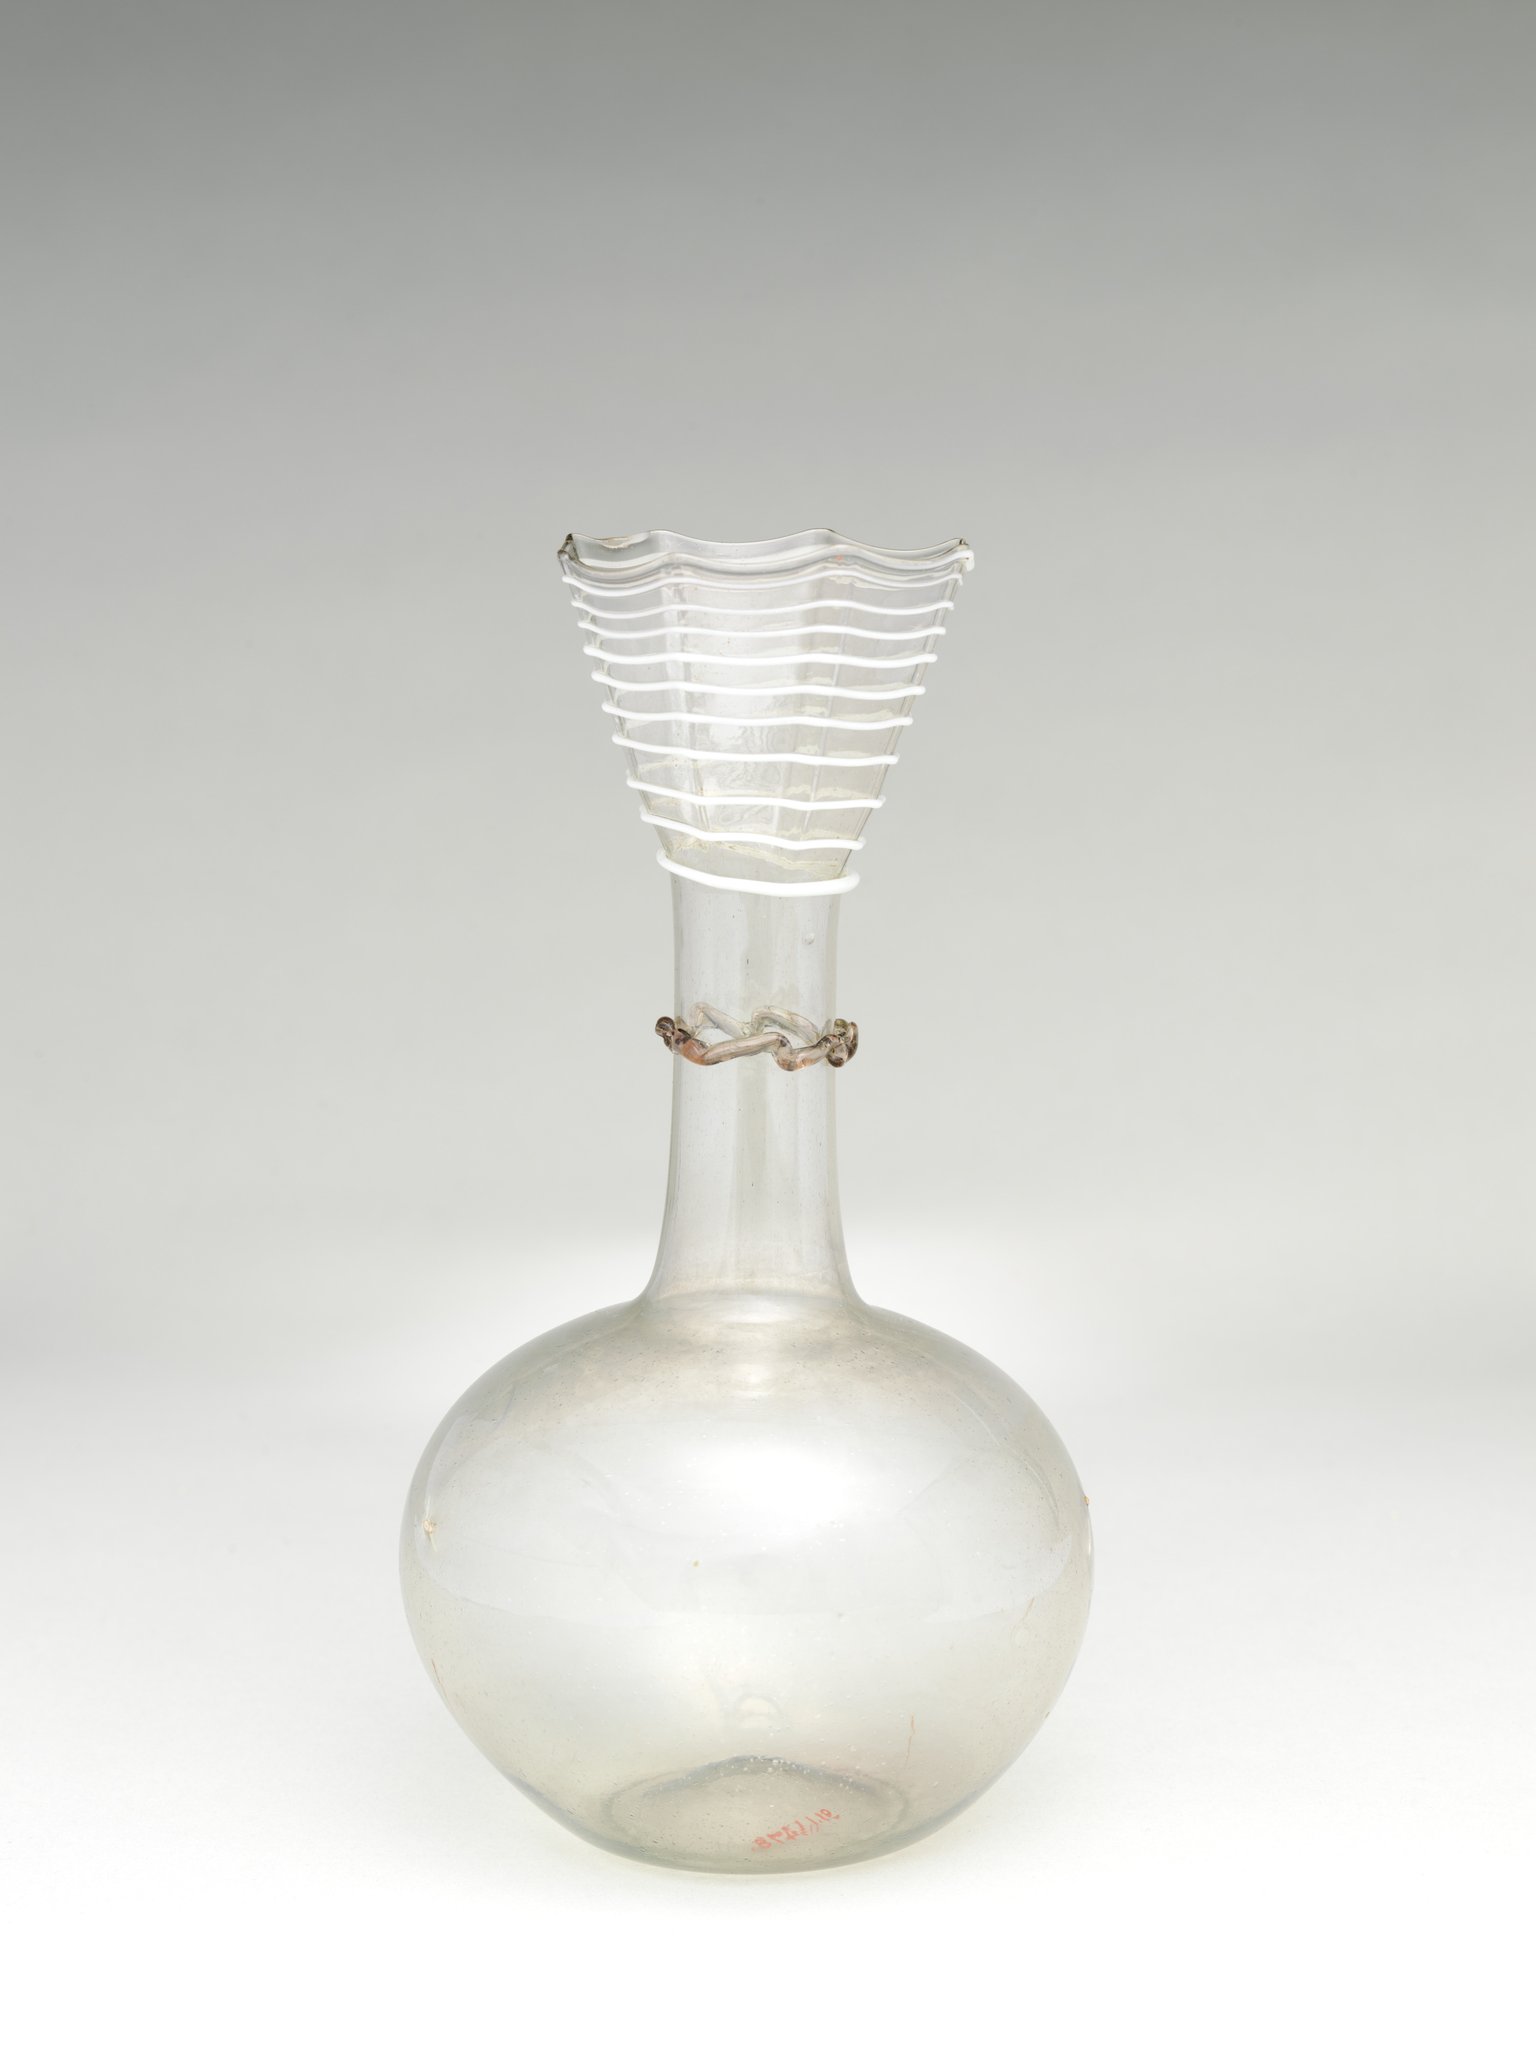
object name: bottle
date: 1601-1700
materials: glass